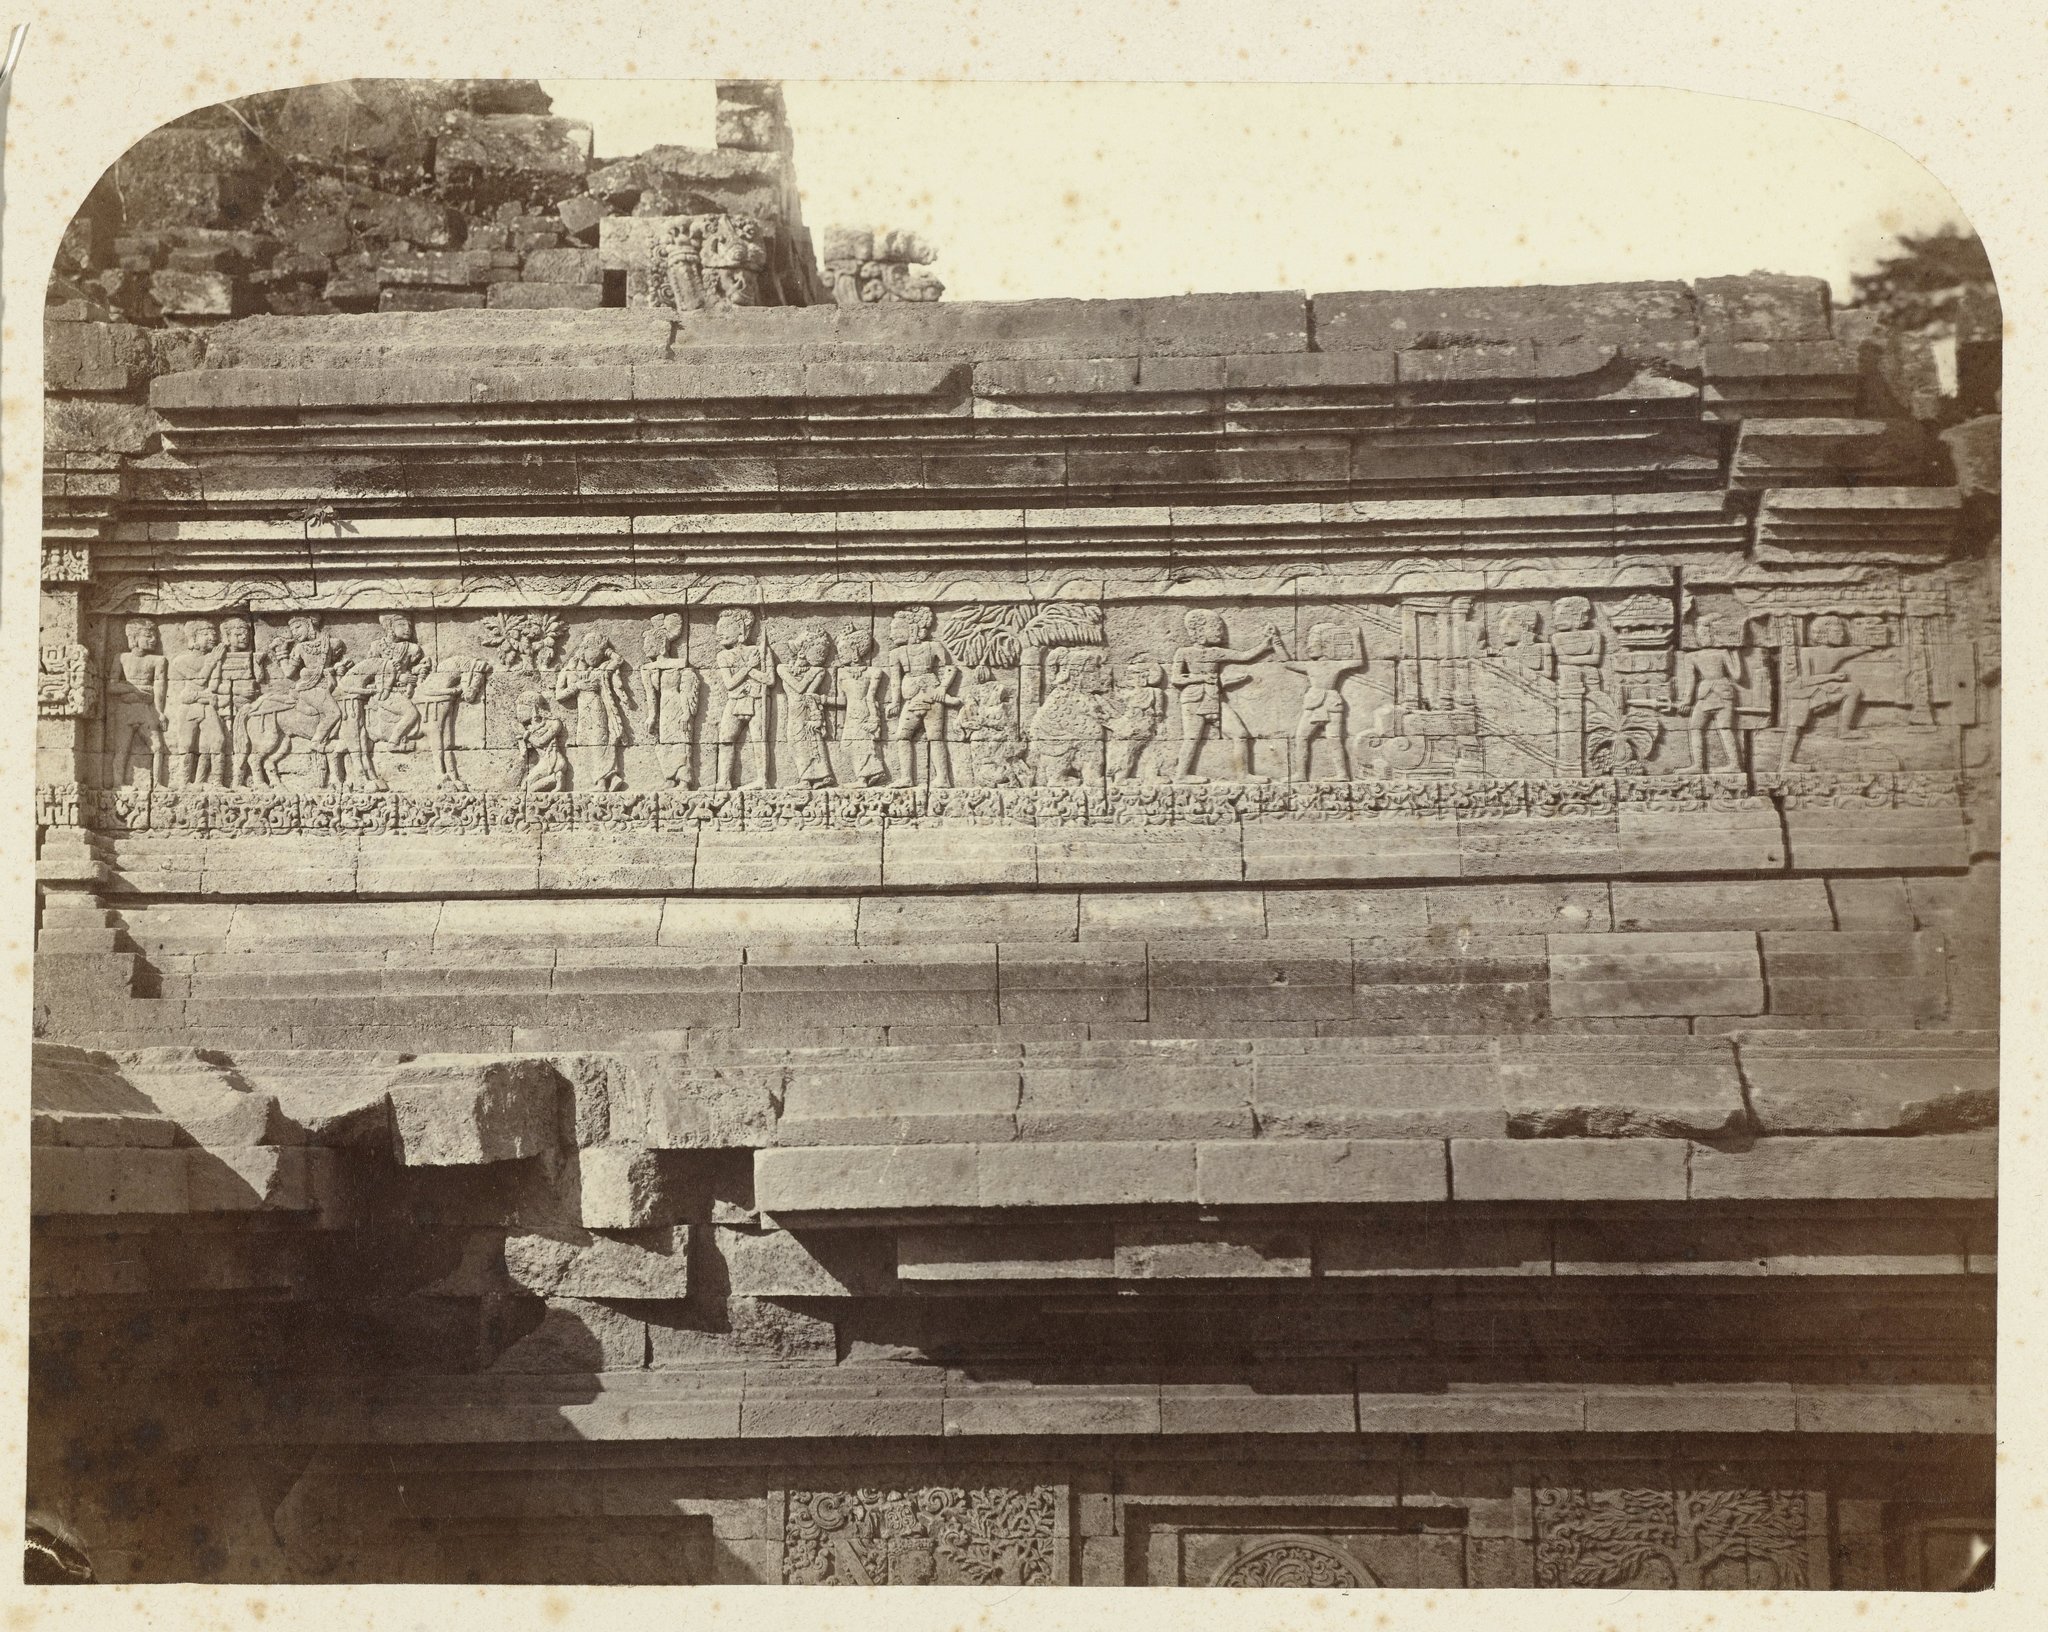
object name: photograph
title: Basreliëf van den tempel (noordzijde) 1e gaanderij. Panataran (r. Kediri)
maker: isidore kinsbergen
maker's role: fotograaf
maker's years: 1821-1905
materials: cardboard, paper, photographic support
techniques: albumen print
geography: java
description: Candi Panataran (Temple Complex), main Temple; Krishnayana relief no 6 (Krishna's rivals take treasures and women form the city of Dvaravati), second narrative register north side. Panataran, Blitar district, East Java province 1323-1347 AD.